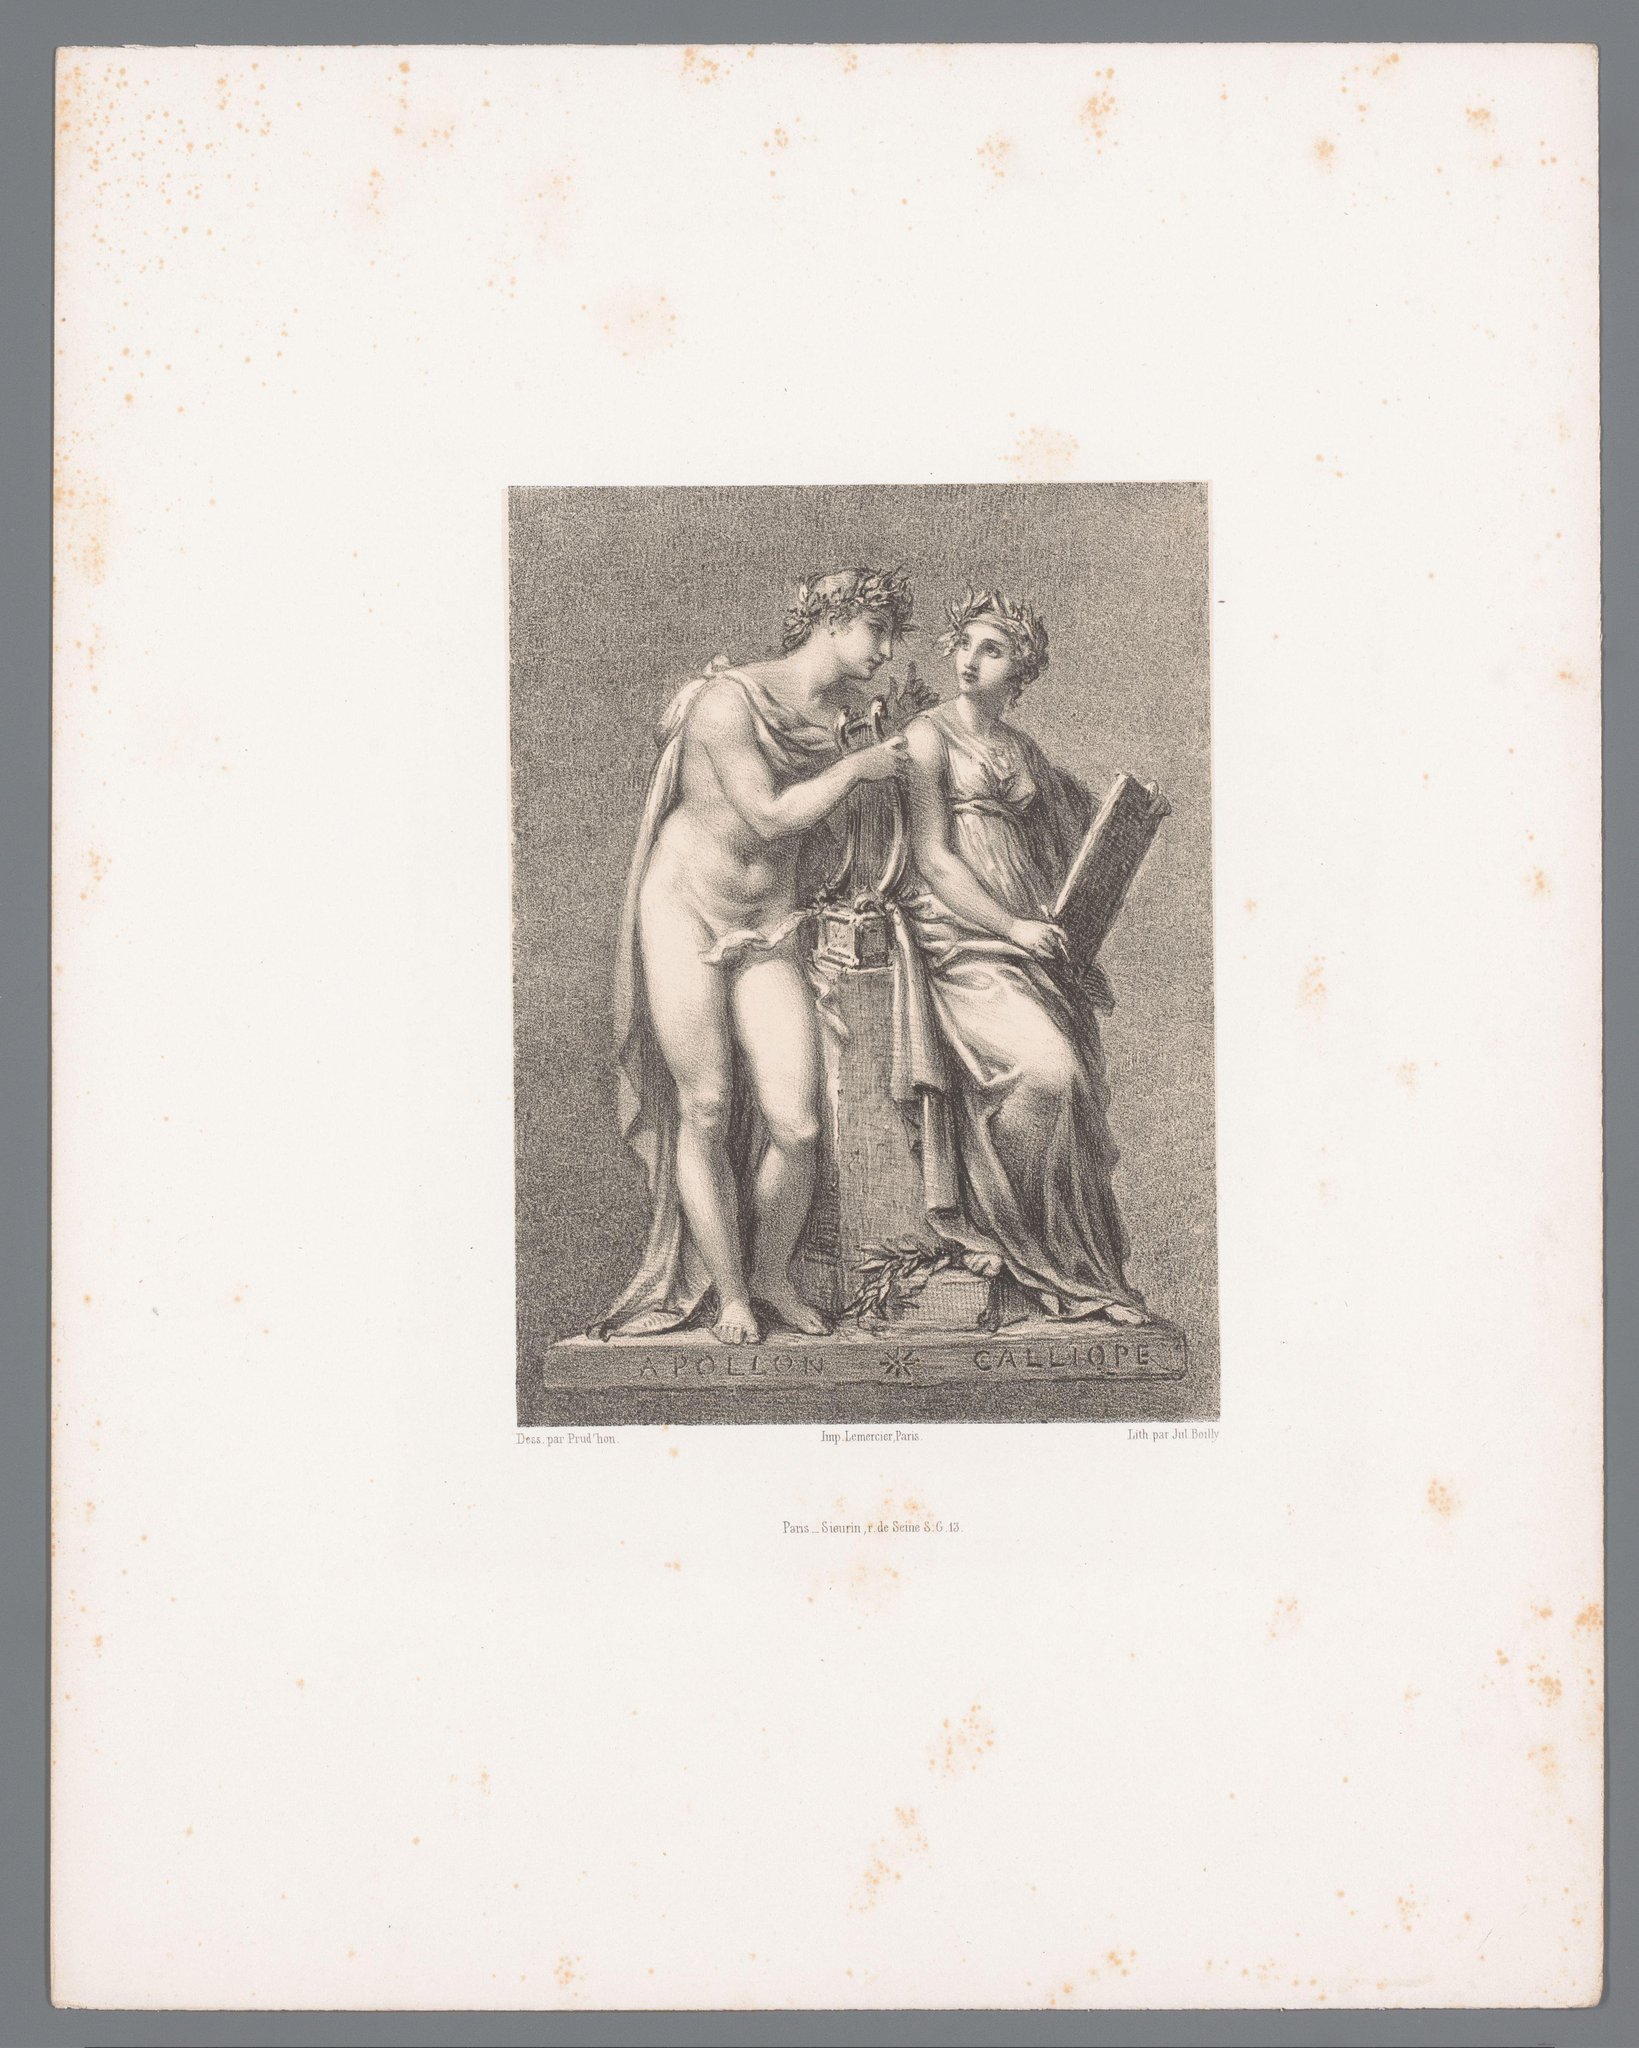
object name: print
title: Apollon et les Muses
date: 1851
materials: paper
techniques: lithograph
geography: paris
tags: calliope (one of the muses); 'calliope' (ripa), (story of) apollo (phoebus)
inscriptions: collector's mark: Lugt 2228a, collector's mark: Lugt 2760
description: Deze prent maakt deel uit van een omslag met zeven prenten.